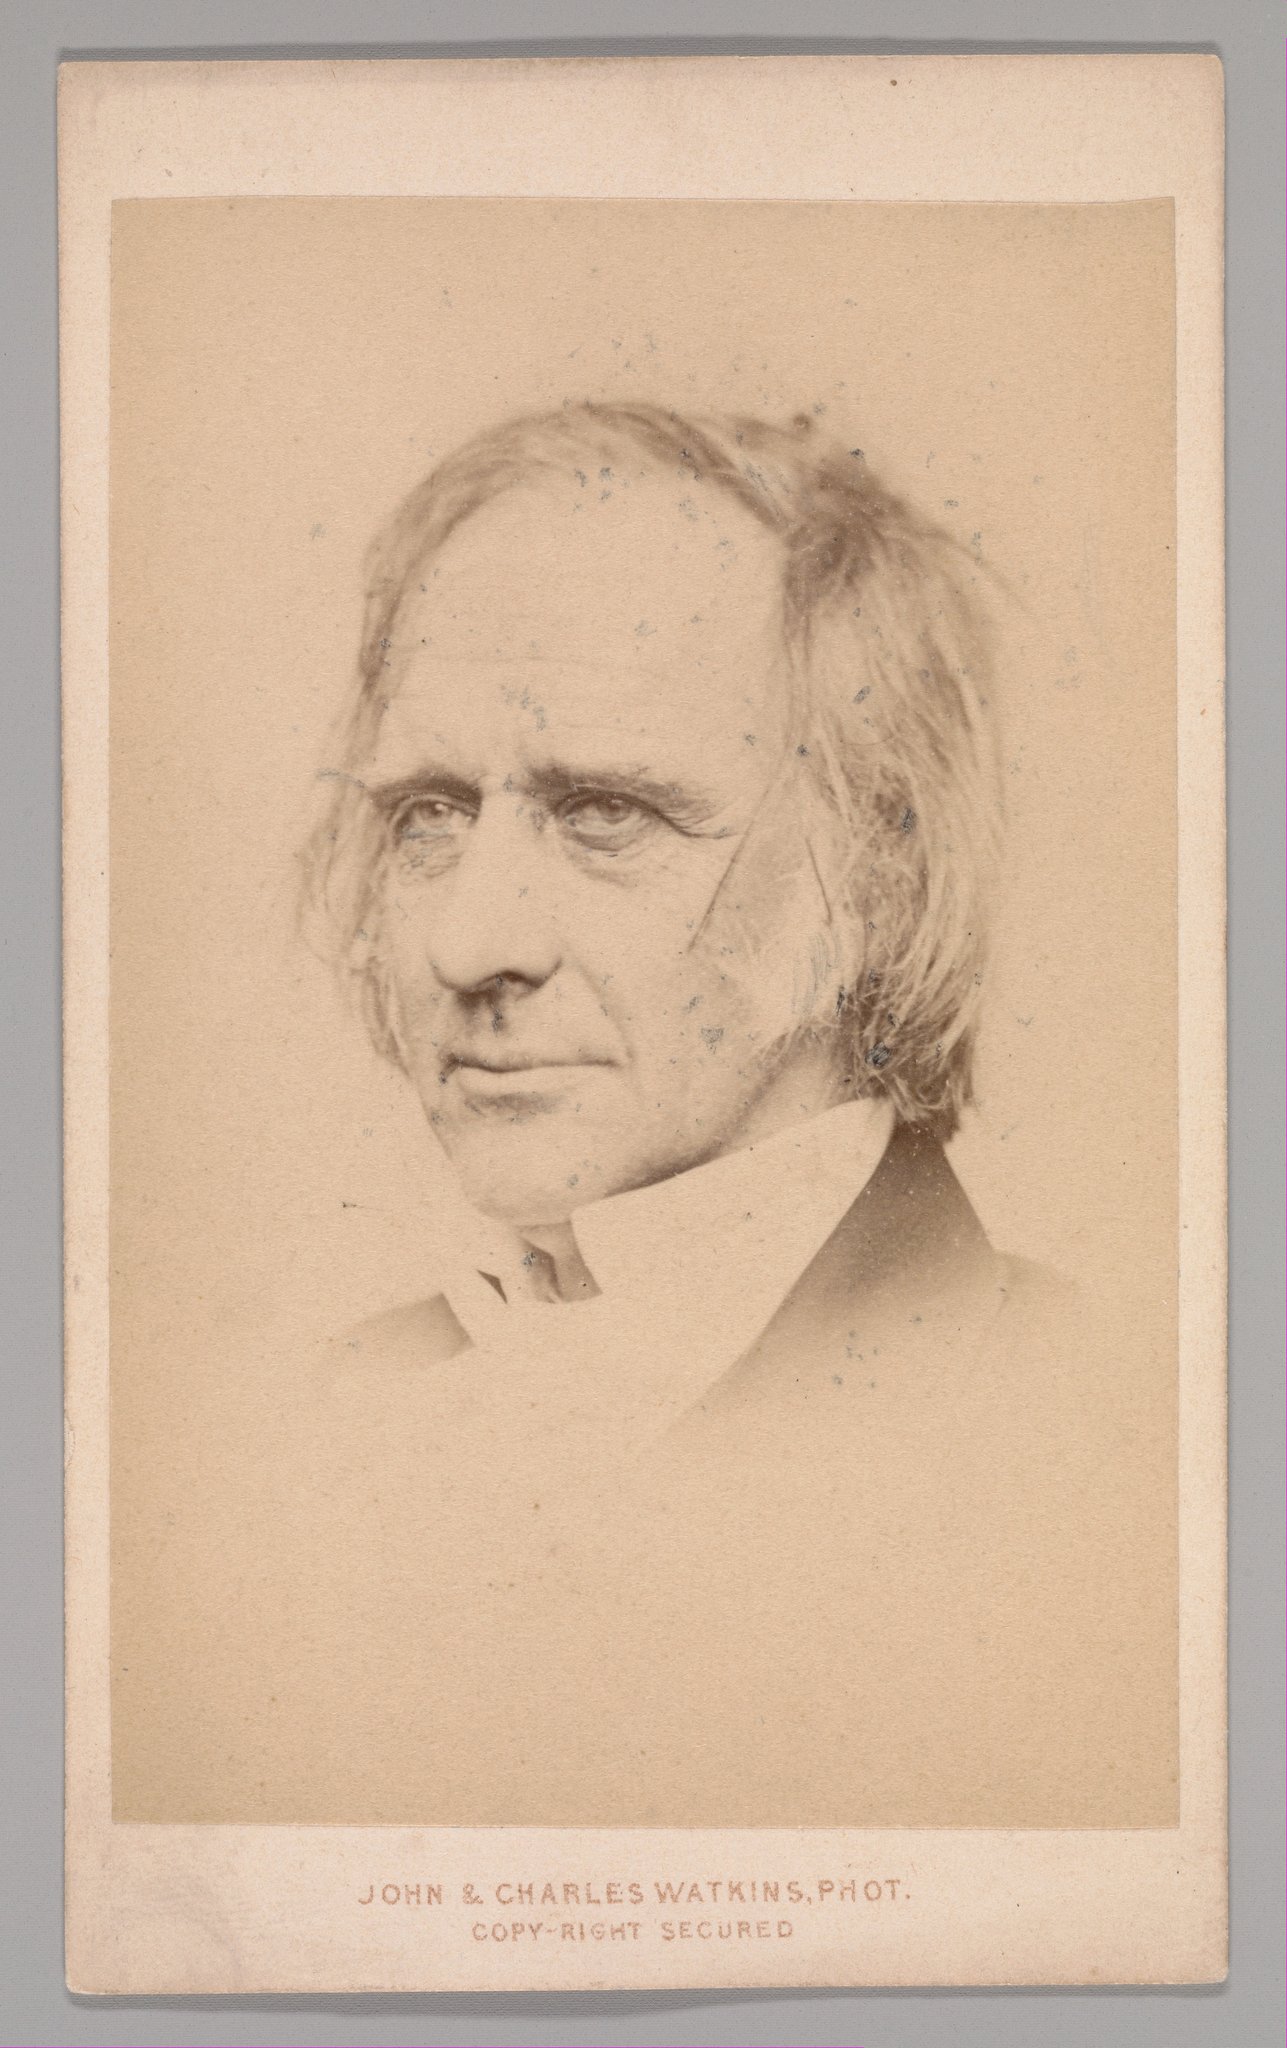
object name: carte de visite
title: [Unknown Subject]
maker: john and charles watkins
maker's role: photography studio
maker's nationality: british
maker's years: 1840-1875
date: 1860-1869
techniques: albumen silver print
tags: men,portraits